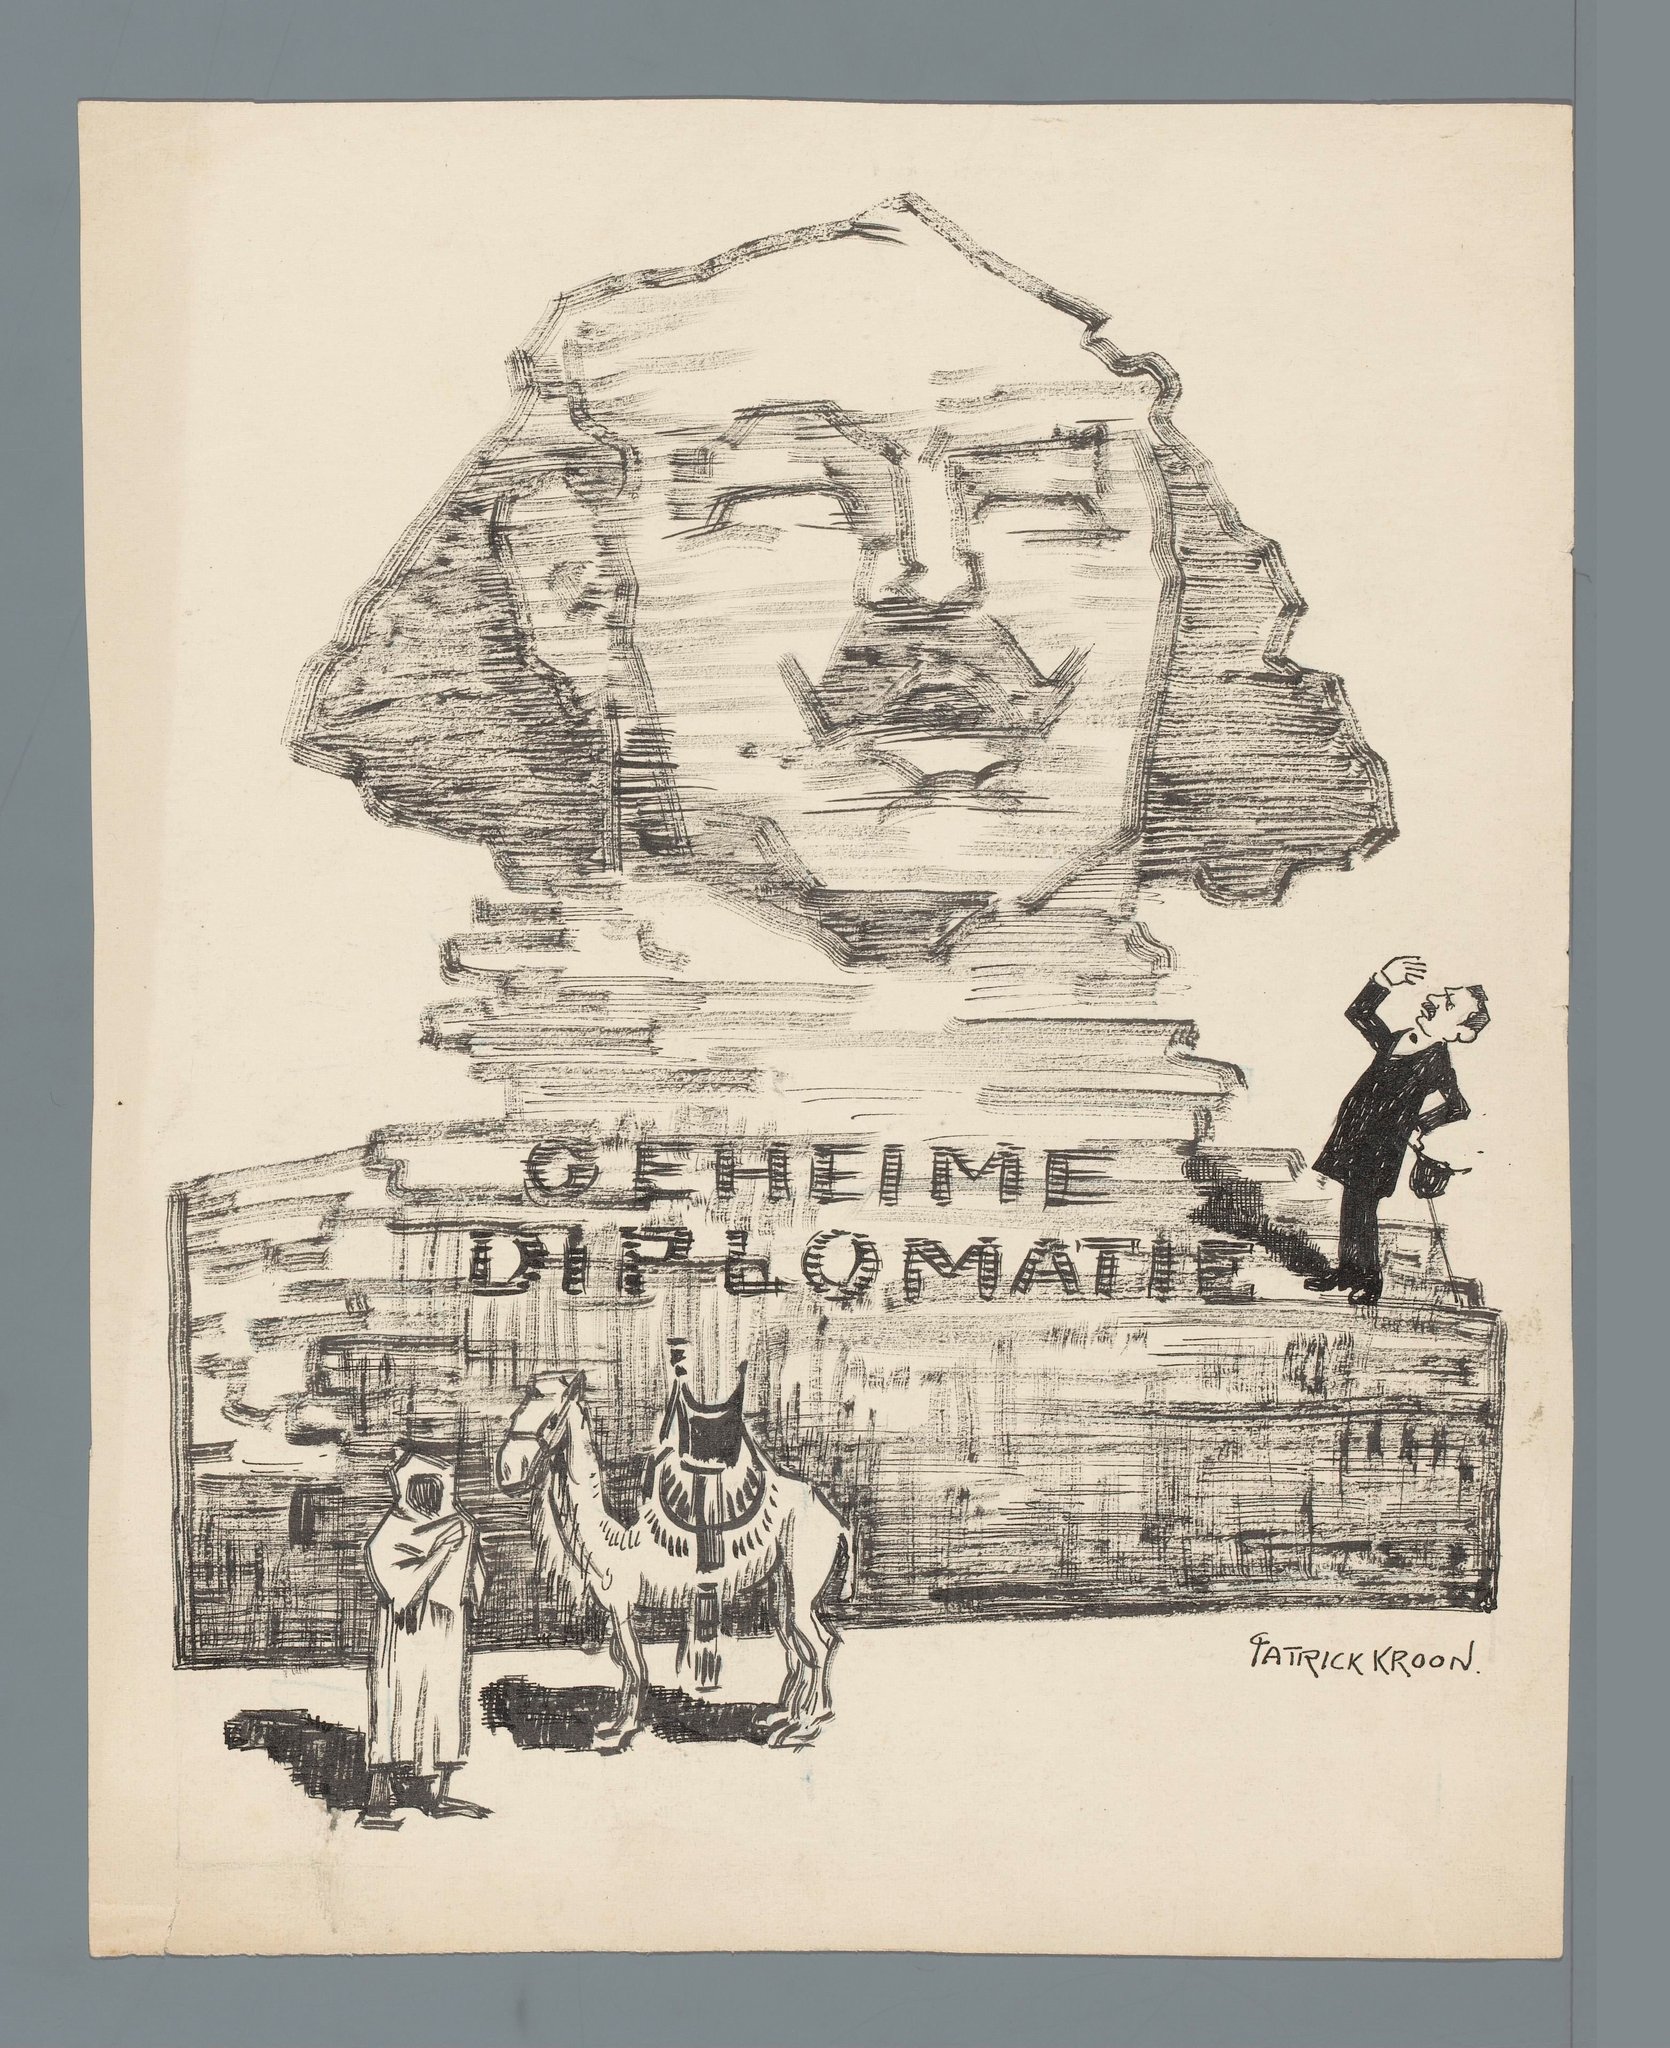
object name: cartoon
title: Geheime diplomatie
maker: patricq kroon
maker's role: draughtsman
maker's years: 1862-1941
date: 1920-1930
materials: ink, paper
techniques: pen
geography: netherlands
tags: political caricatures and satires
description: De sfinx van Gizeh als symbool voor de geheime diplomatie. Ontwerp voor een politieke spotprent.